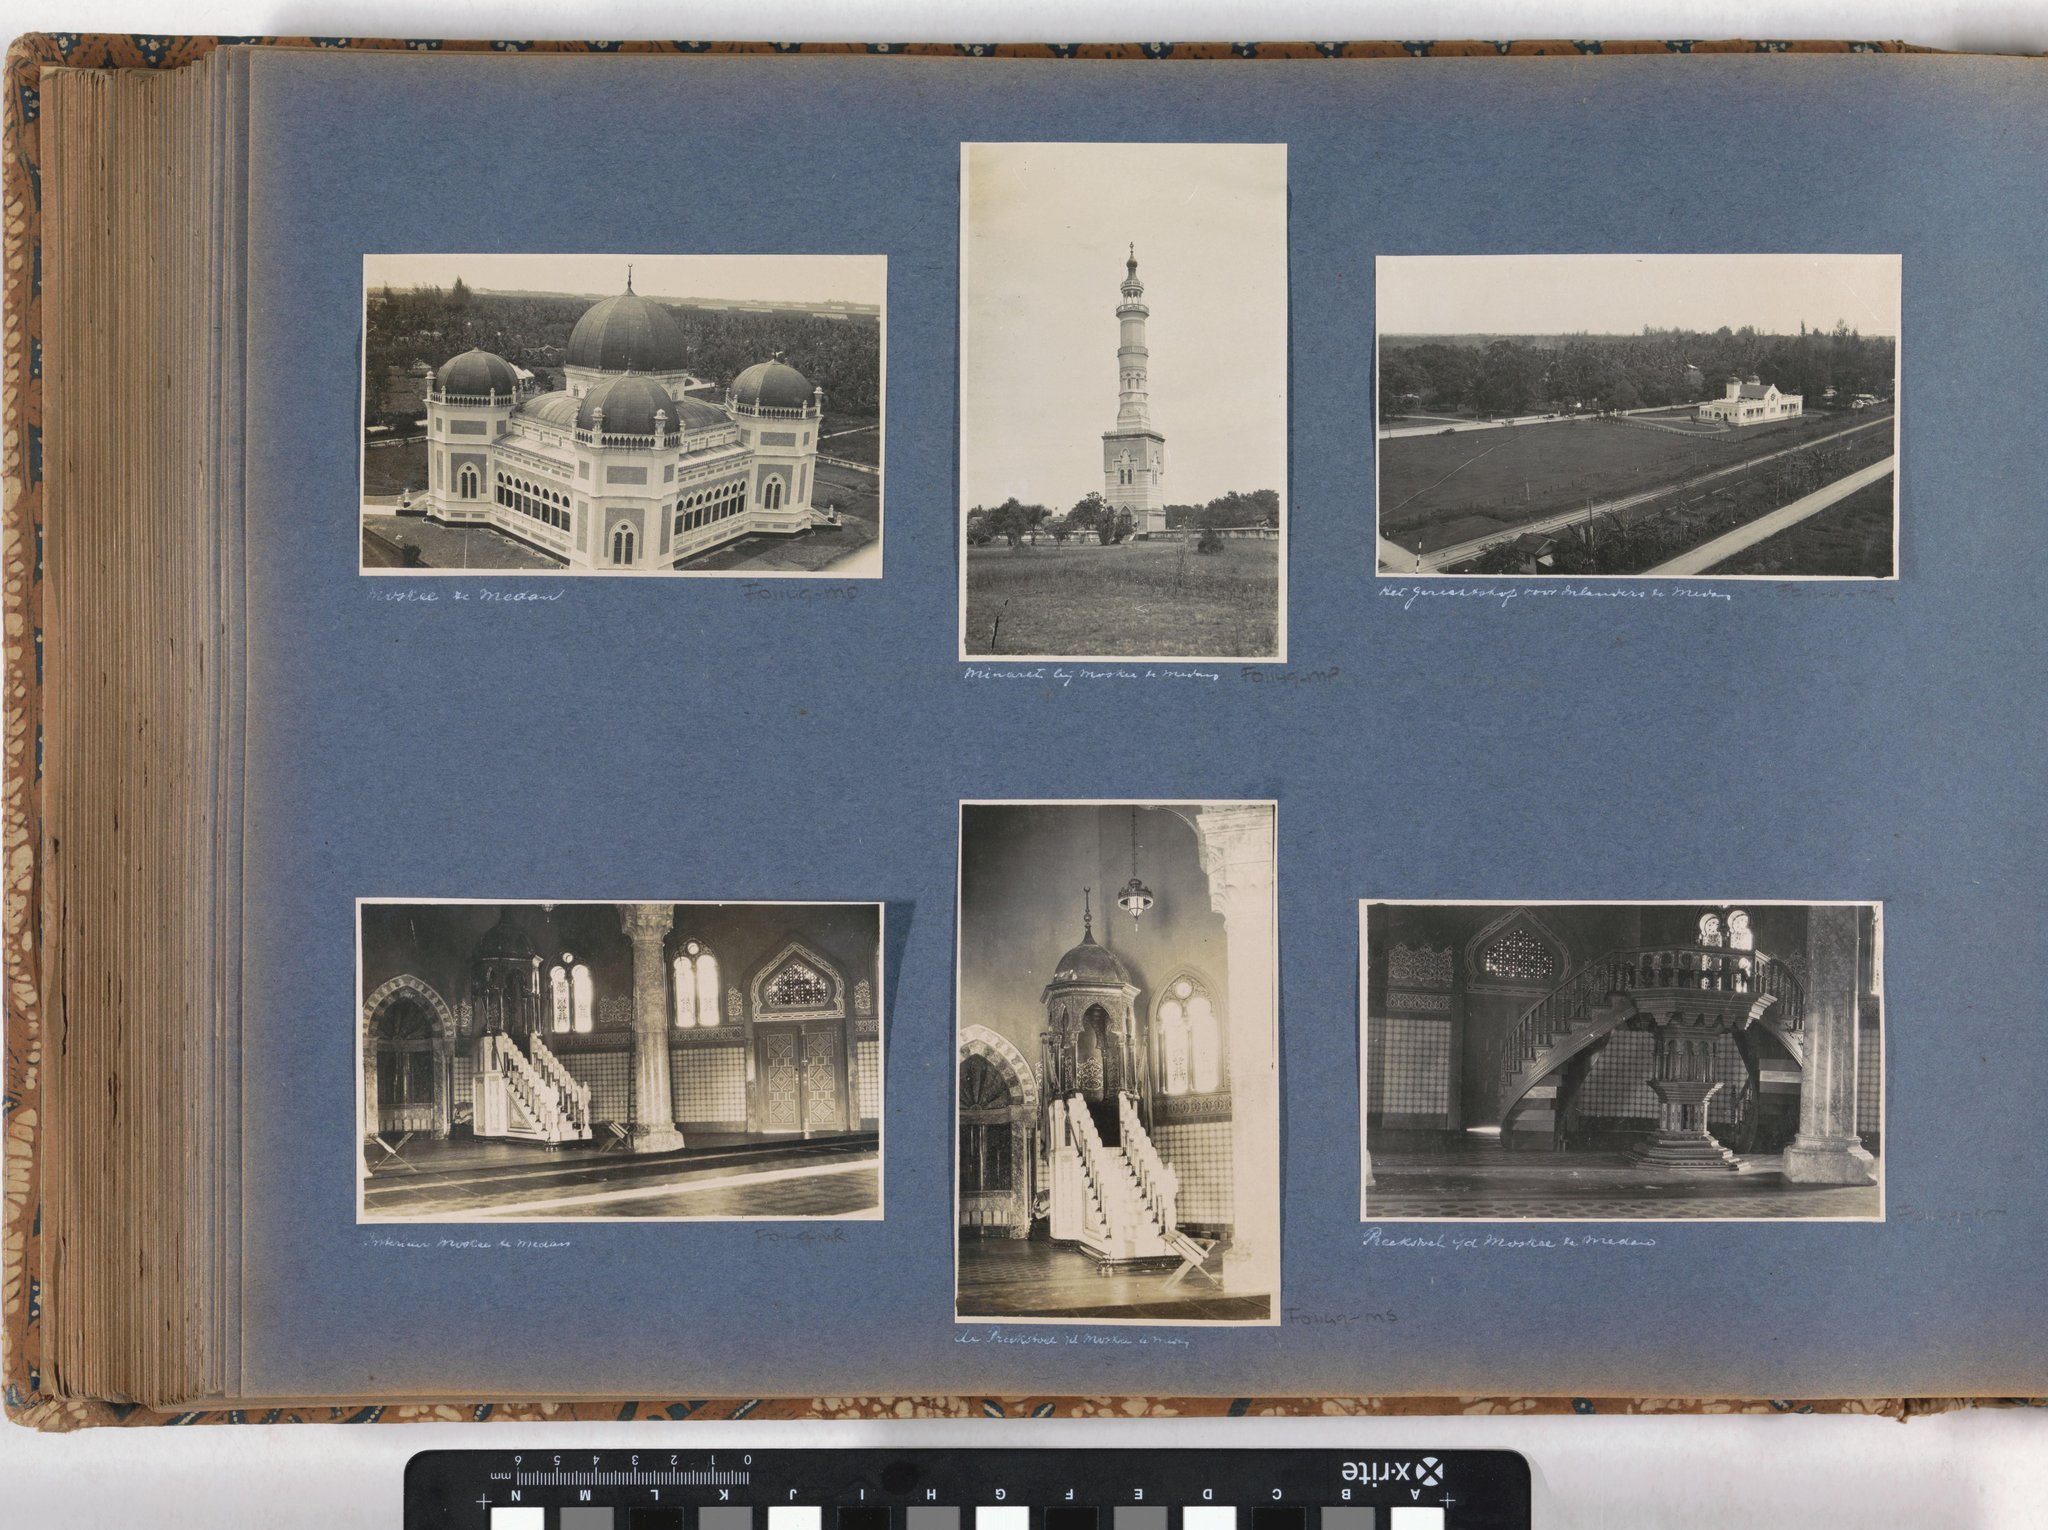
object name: album leaf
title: Preekstoel van de Grote Moskee (Masjid Raya Al Mashun) in Medan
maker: Anonymous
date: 1900-1920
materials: paper, photographic support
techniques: gelatin silver print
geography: medan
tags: pulpit, ambo, chancel, temple, shrine ~ islam, mohammedanism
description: Onderdeel van reisalbum met foto's van bedrijvigheid en bezienswaardigheden op Sumatra en Java en van de reis naar en van Nederlands-Indië.